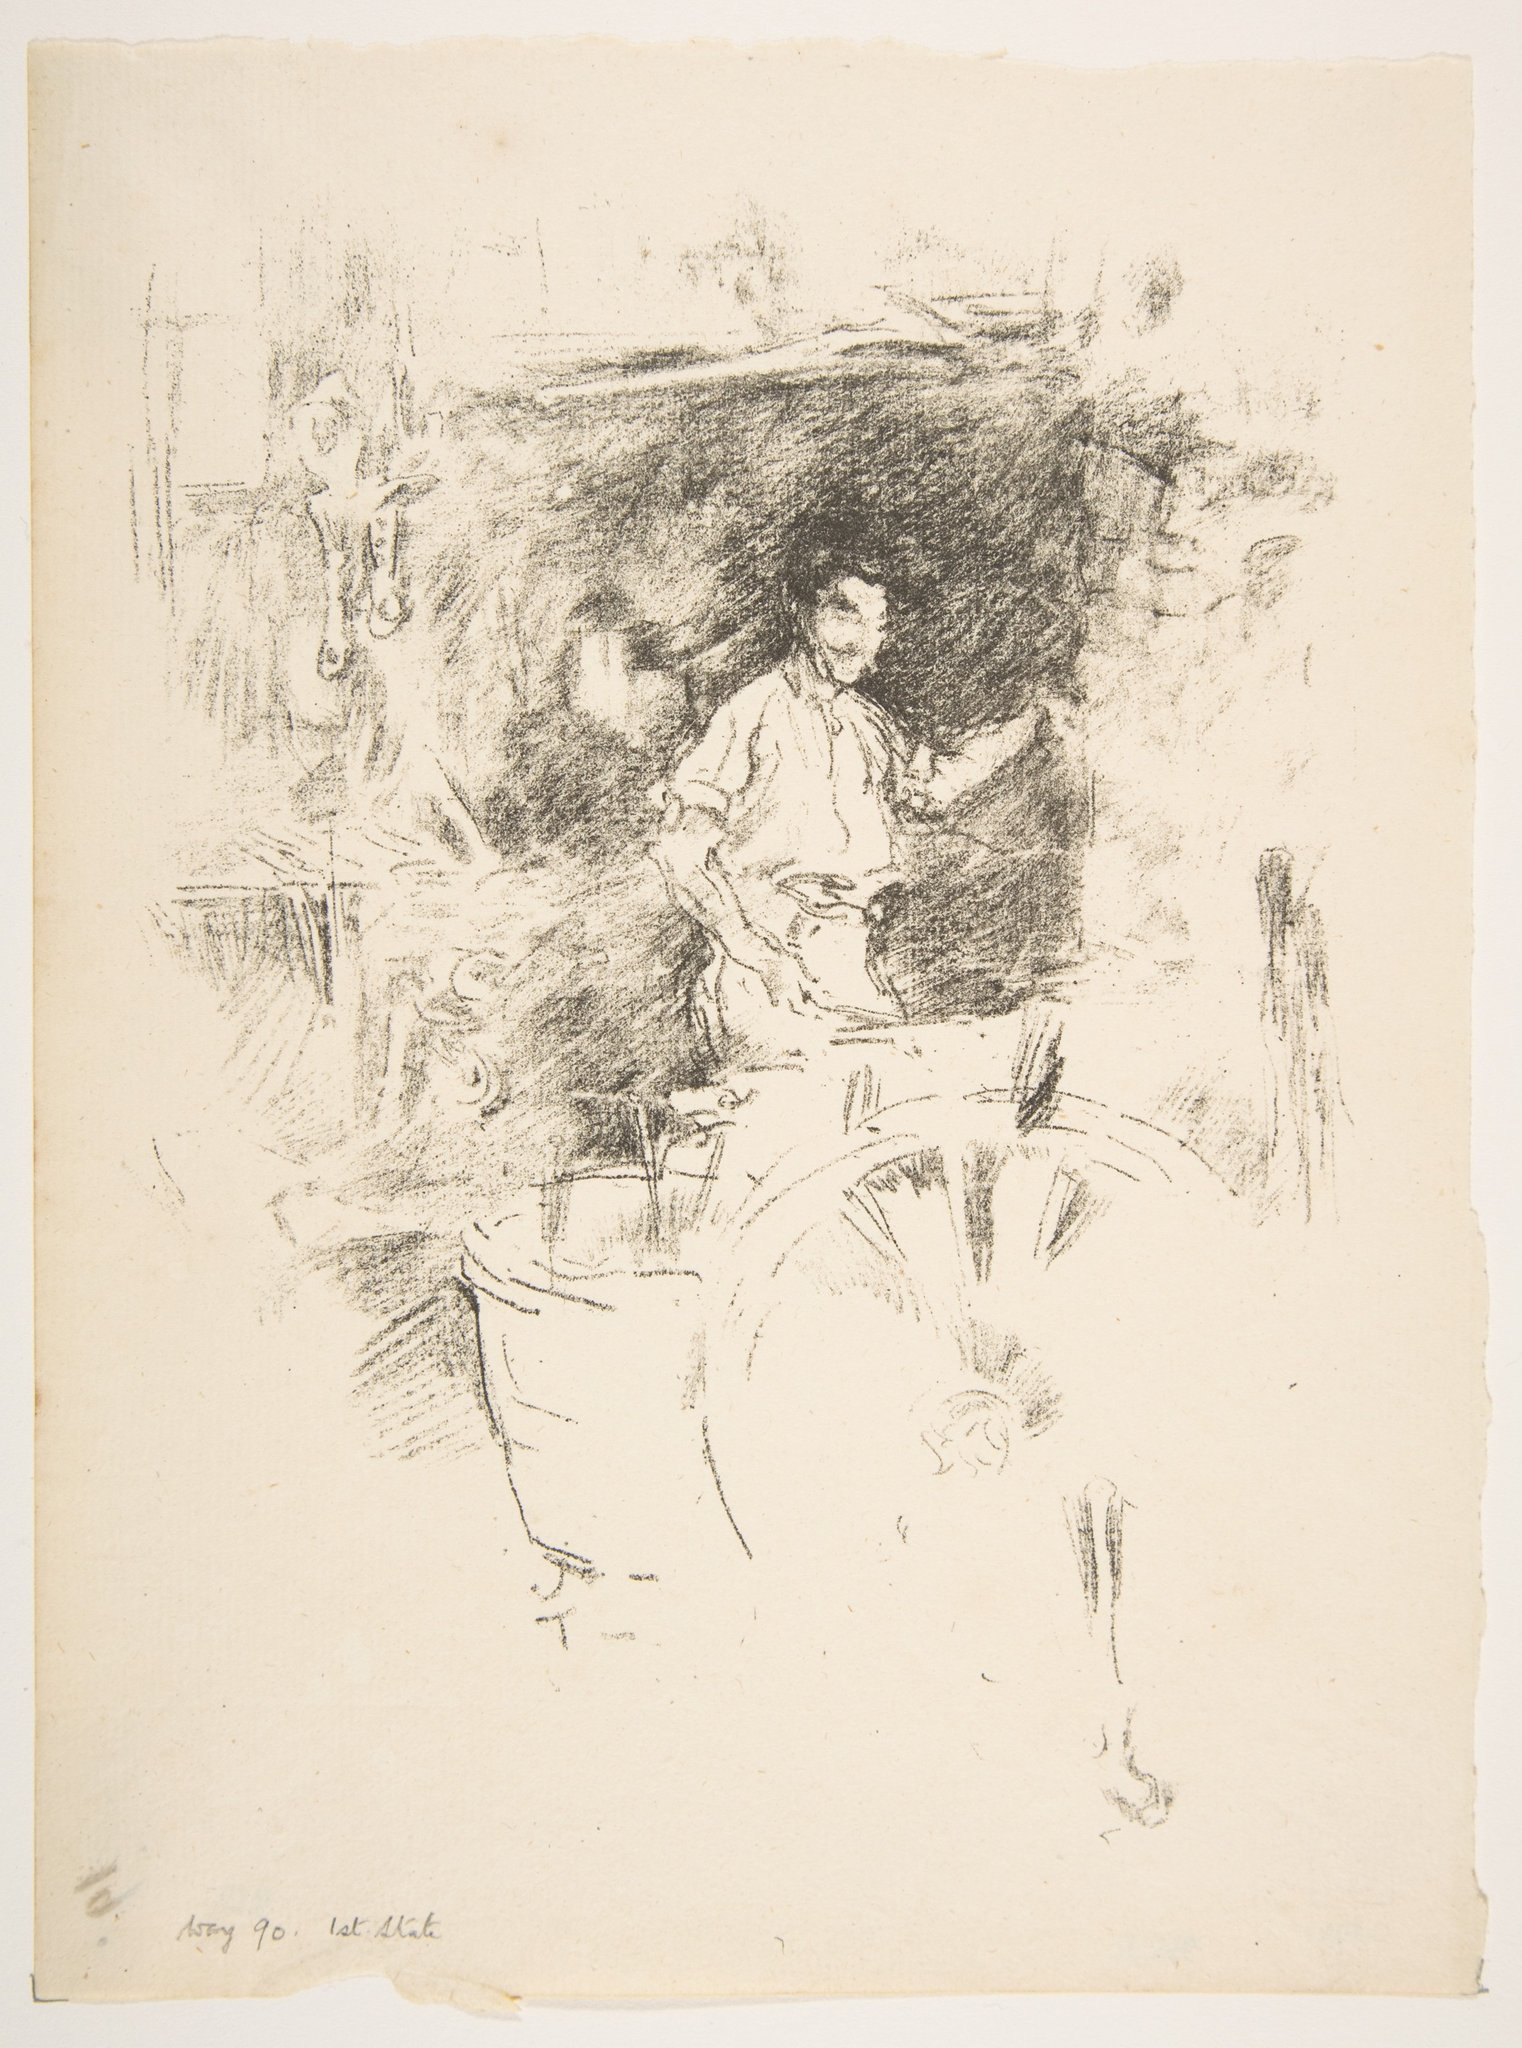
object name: print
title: The Blacksmith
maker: james mcneill whistler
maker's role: artist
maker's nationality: american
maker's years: 1834-1903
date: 1895-1896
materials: ink, paper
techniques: printing, stumping, lithography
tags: blacksmiths